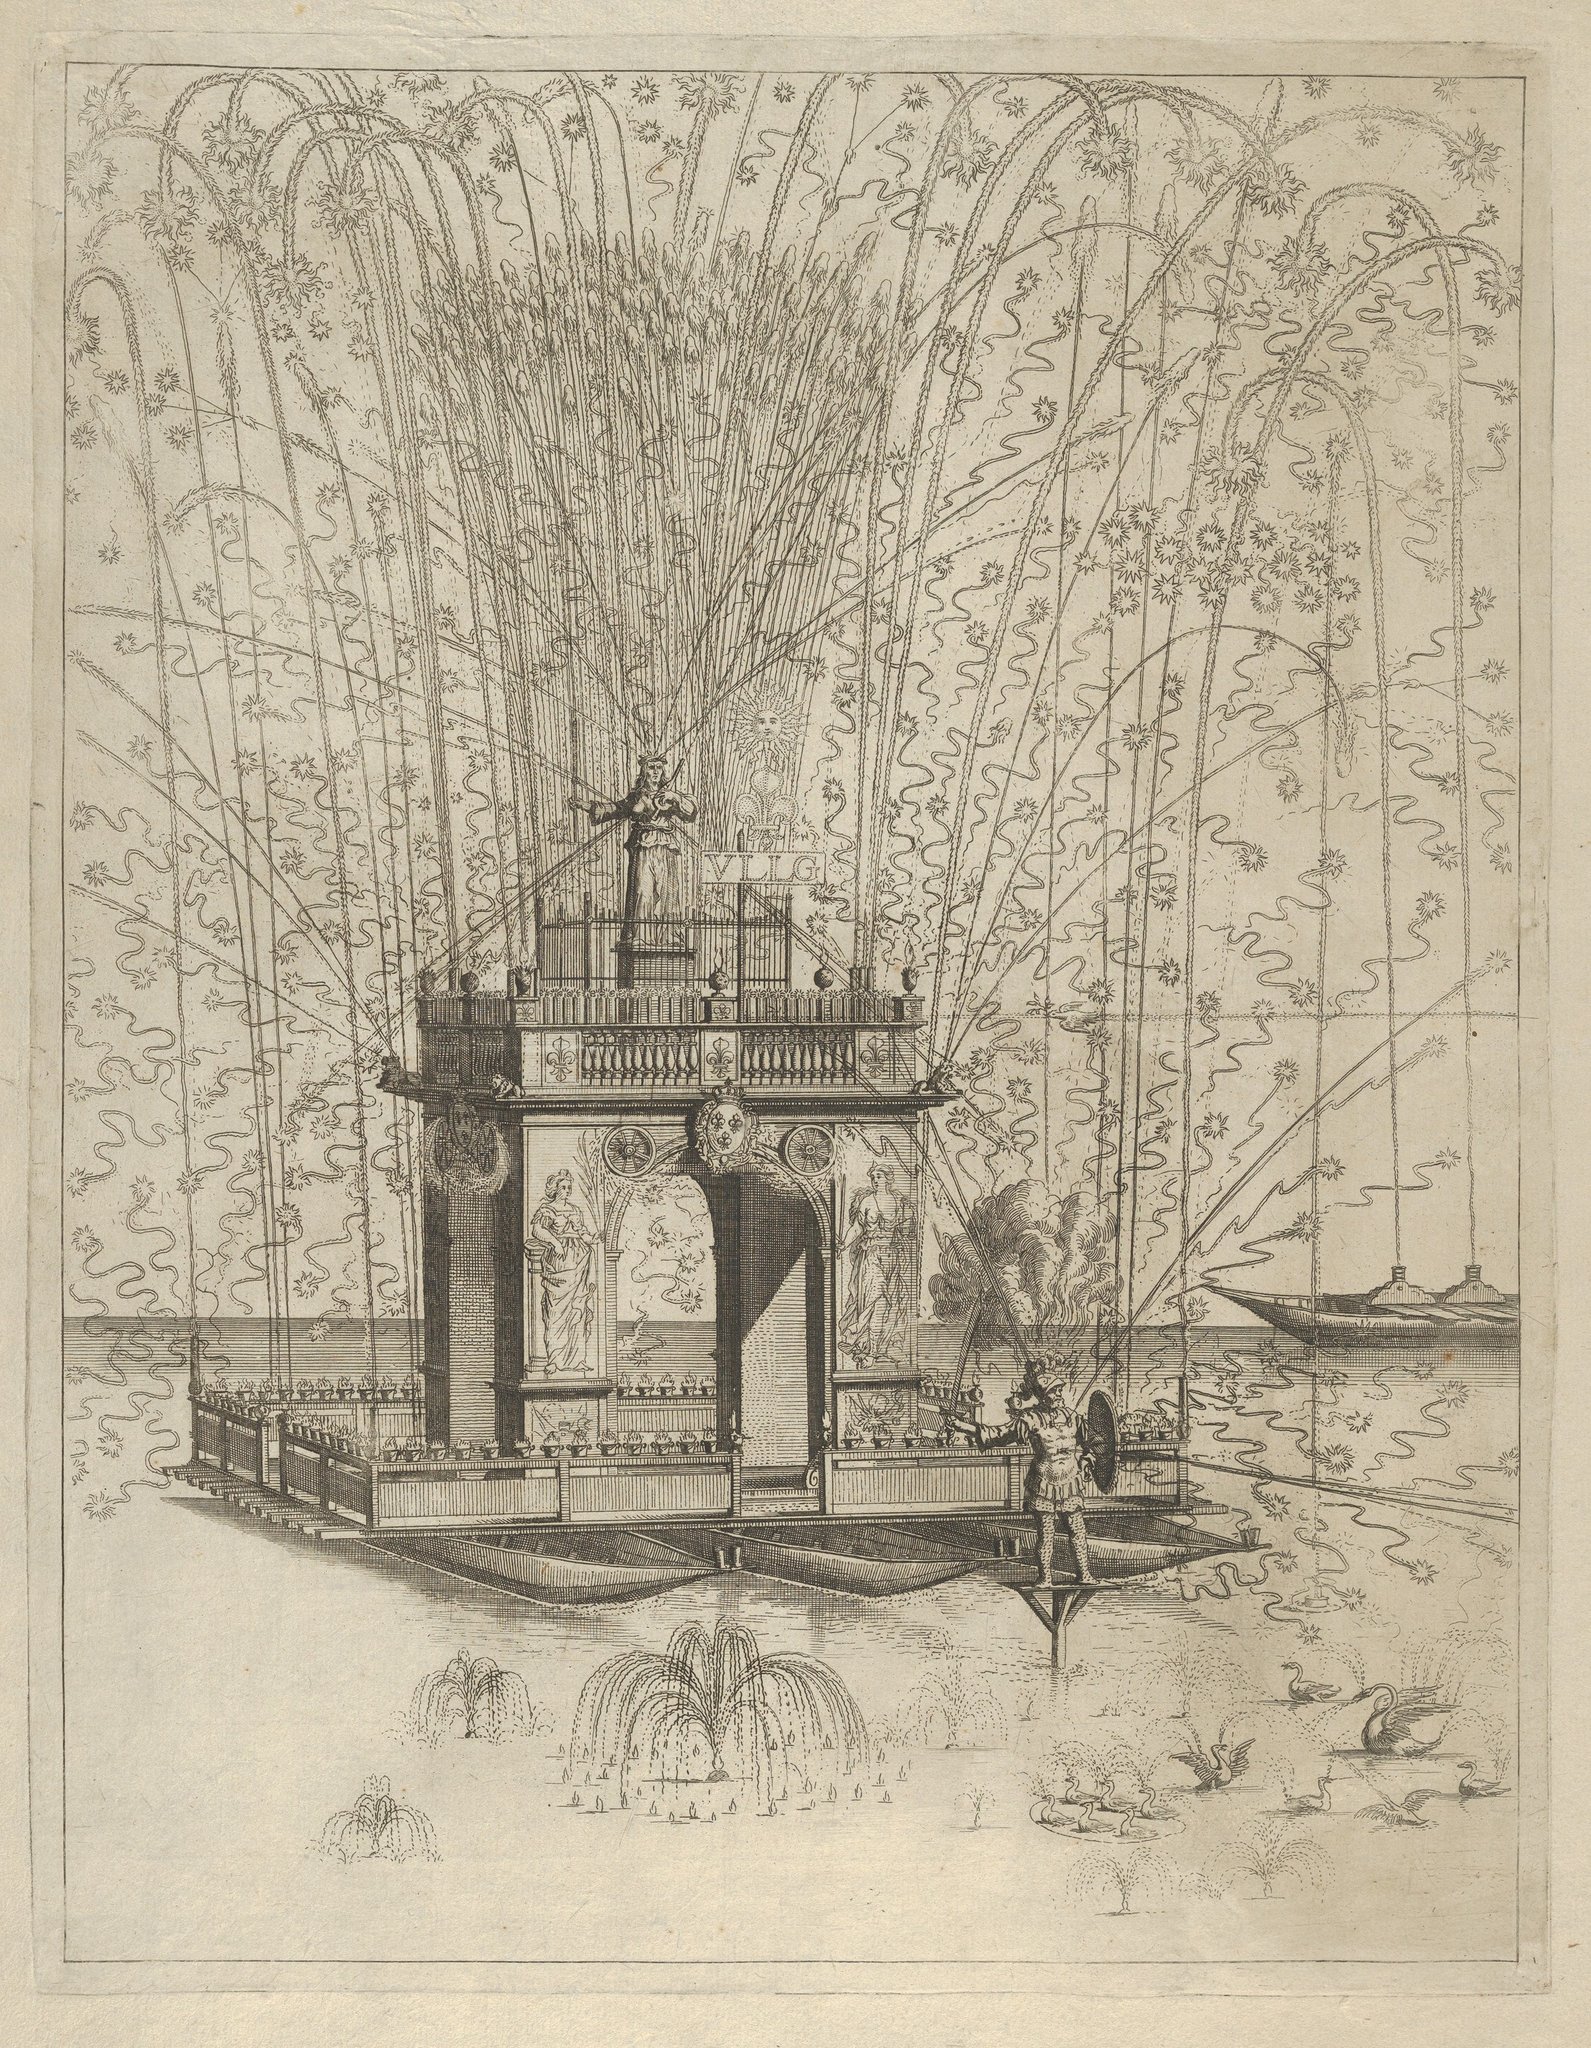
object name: print, fete, ornament architecture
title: Fireworks display with triumphal arch supported by three pontoons on the water, decorated with symbols of Louis XIV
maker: anonymous, french, 17th century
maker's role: artist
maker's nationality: french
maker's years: 1600-1700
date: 1601-1700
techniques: etching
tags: arches,louis xiv,fireworks,ships